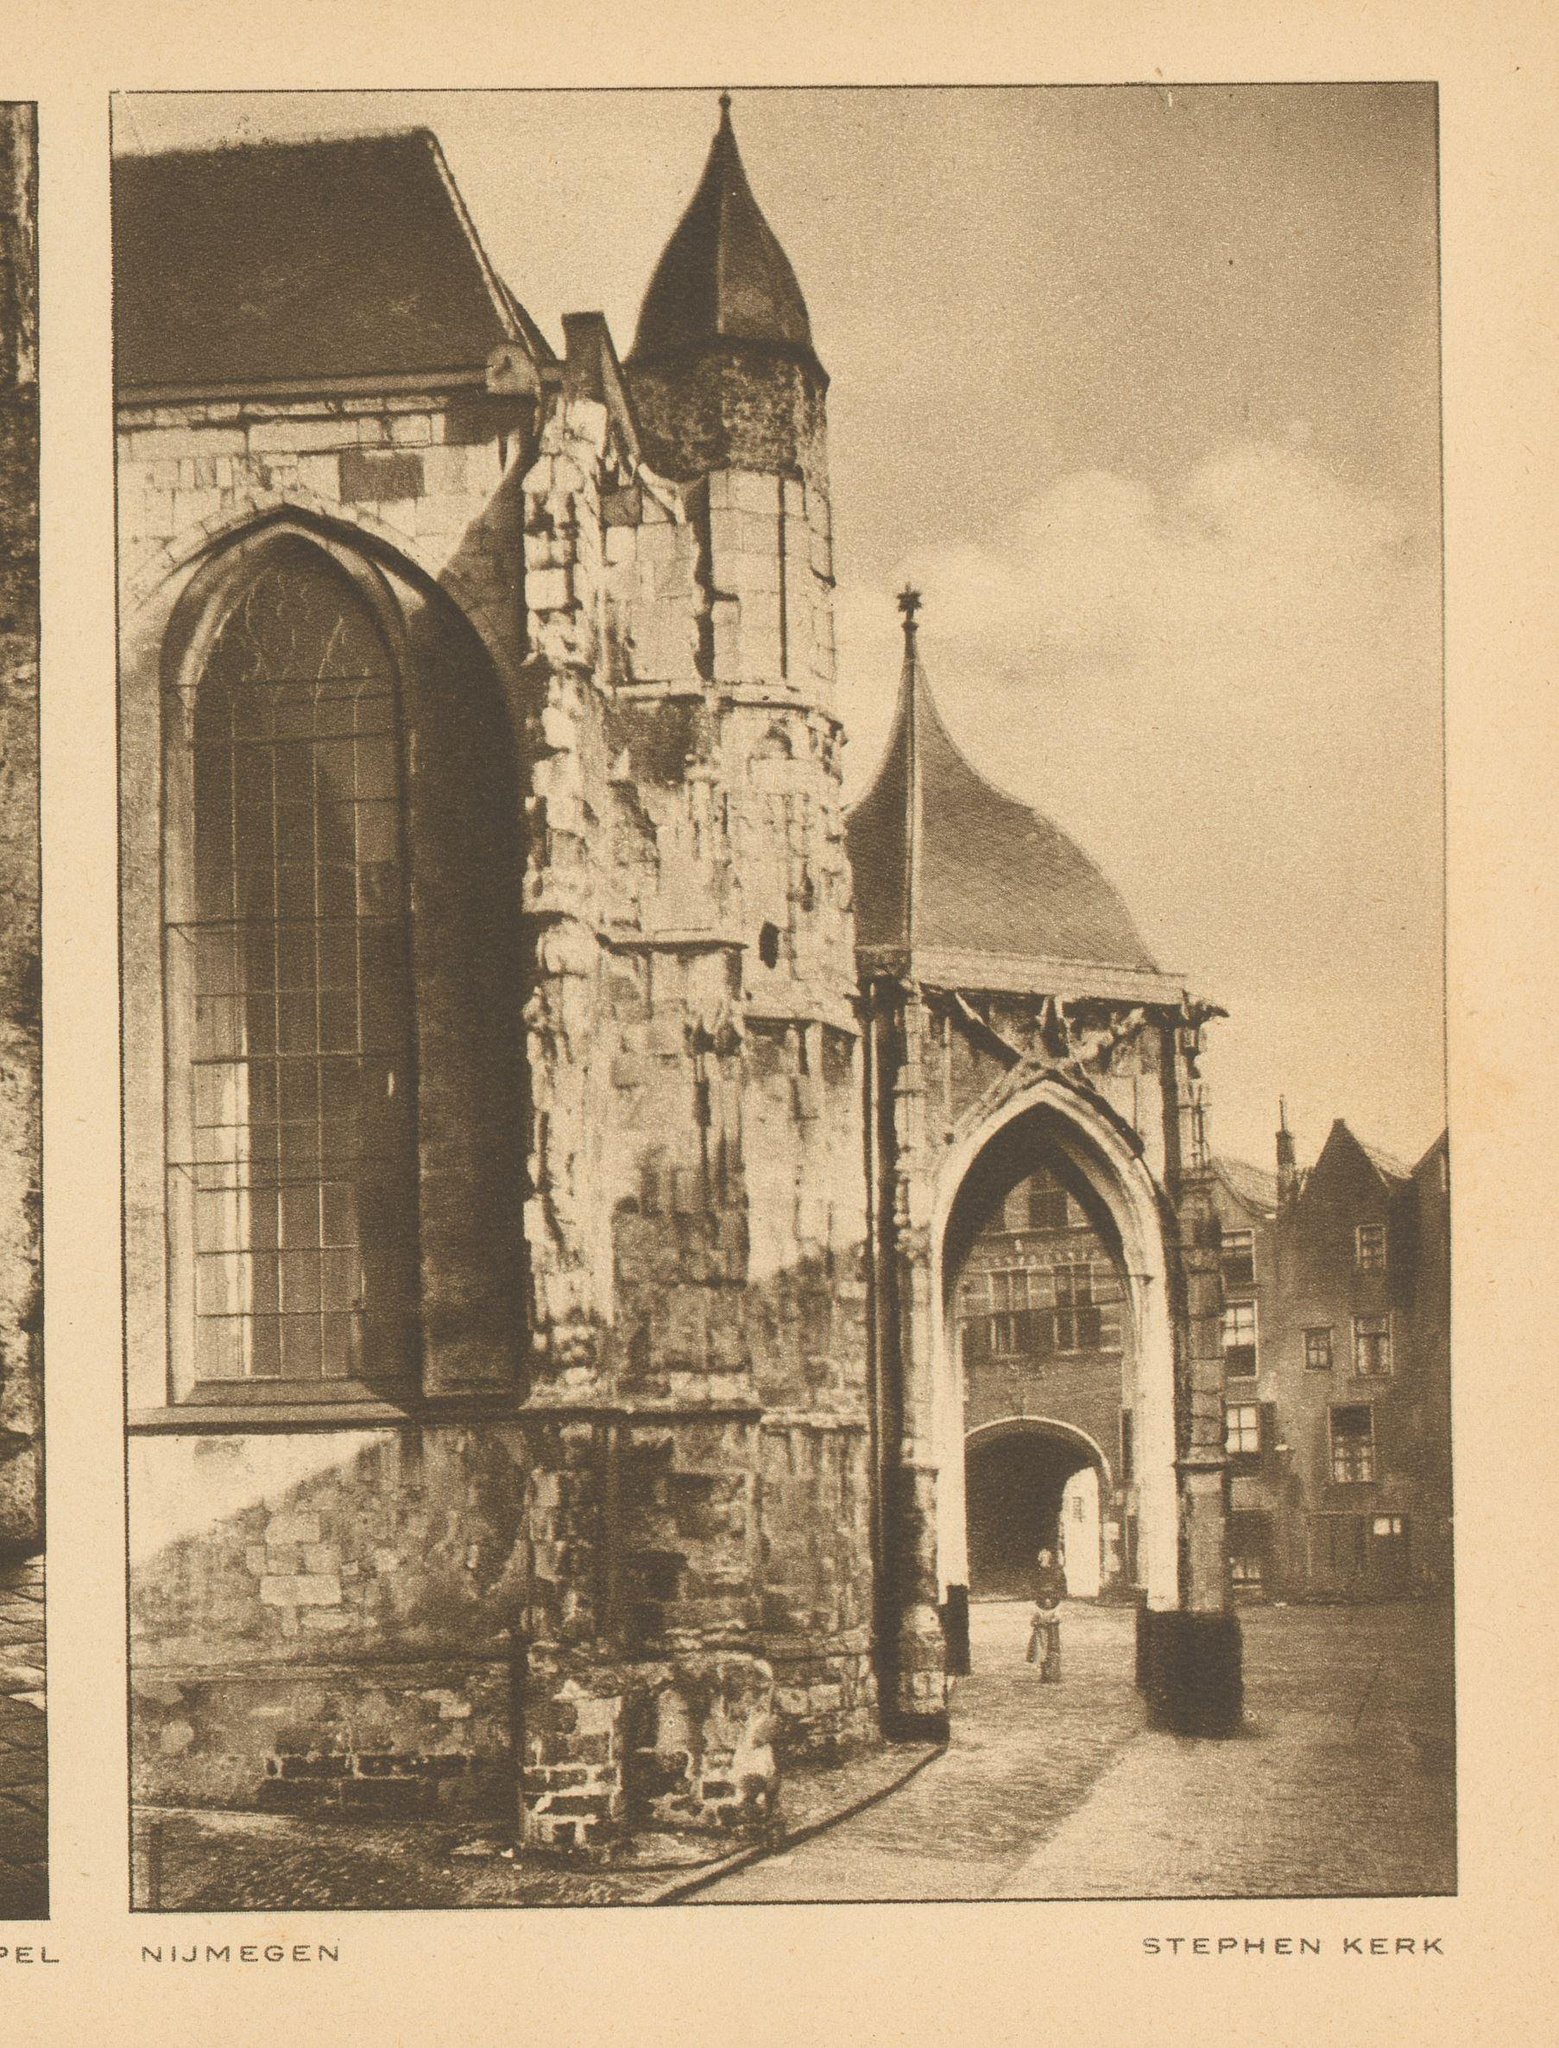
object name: album leaf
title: Gezicht op de Grote of Sint-Stevenskerk in Nijmegen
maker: Anonymous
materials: paper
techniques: rotogravure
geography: leiden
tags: church (exterior), street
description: Deze prent maakt deel uit van een album.